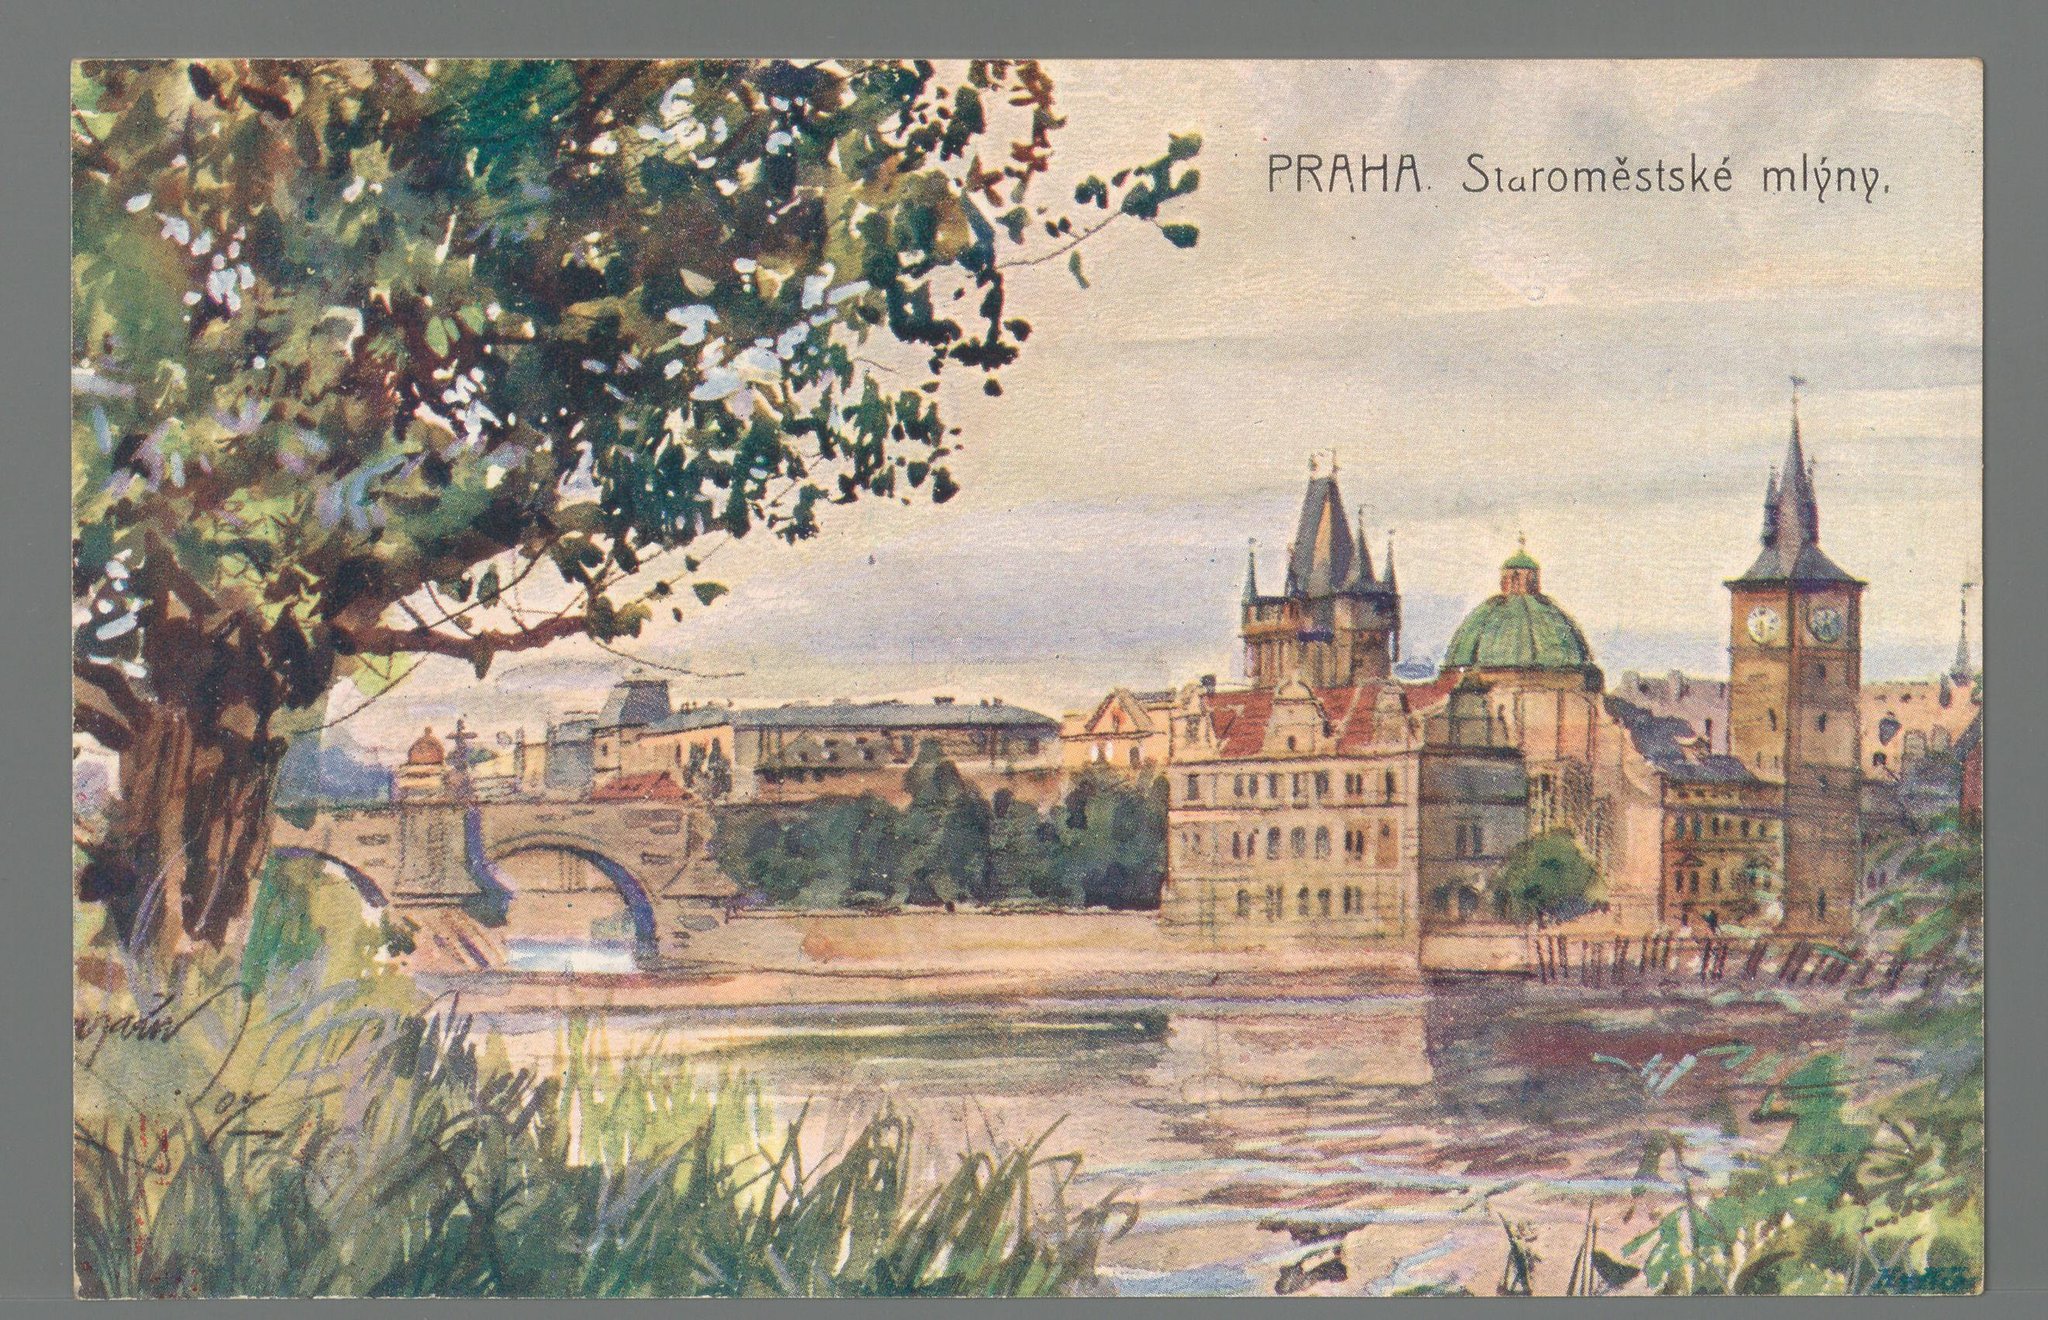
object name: photomechanical print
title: Praha. Staromestské mlýny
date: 1906-1930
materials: cardboard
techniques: color autotype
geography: prague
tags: canals, waters (in city), watermill, prague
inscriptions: inscription: ‘H&H’